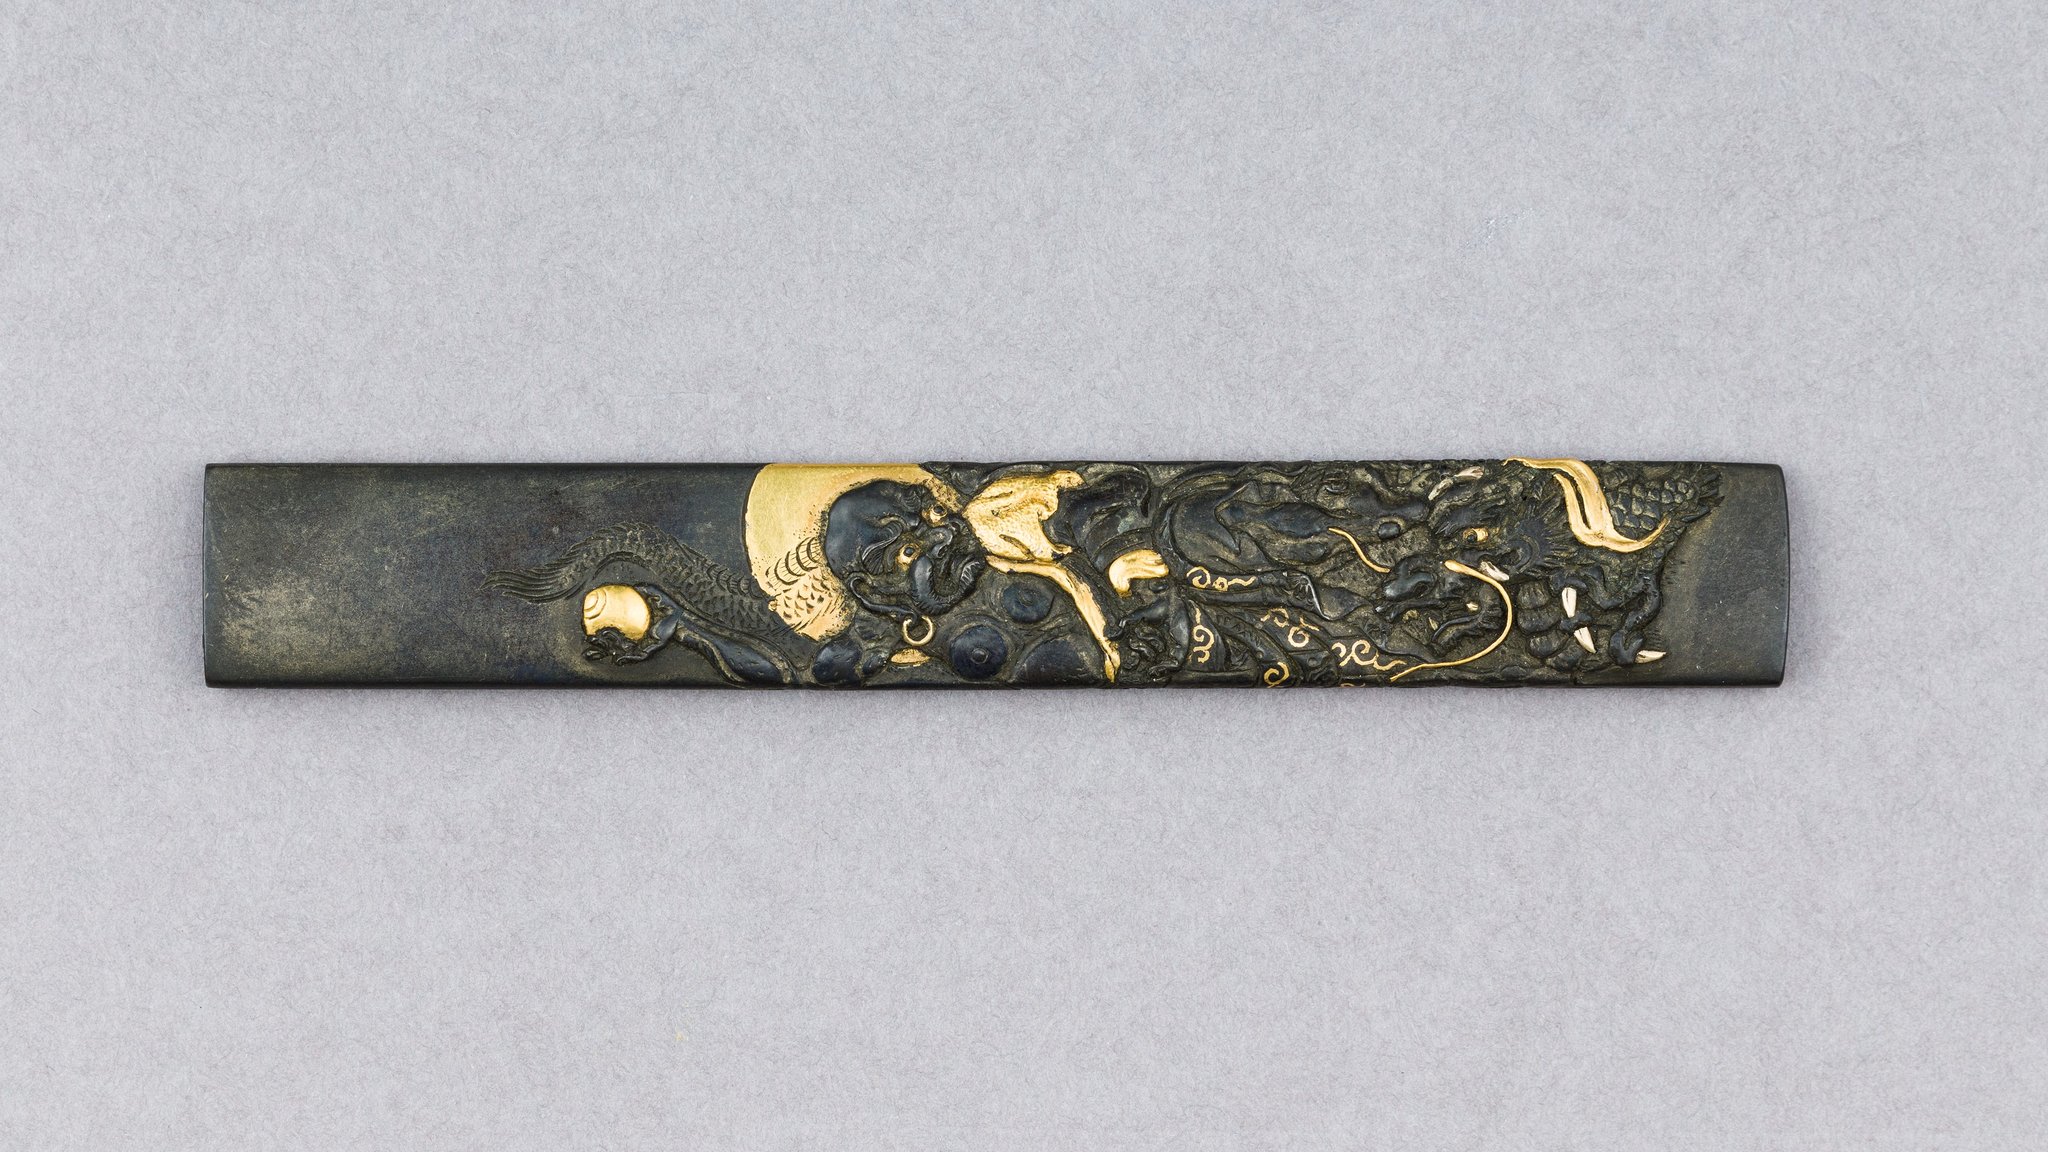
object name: knife handle kozuka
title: Knife Handle (Kozuka)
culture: japanese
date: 1615-1868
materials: gold alloy, silver alloy, gold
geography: japan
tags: men,dragons